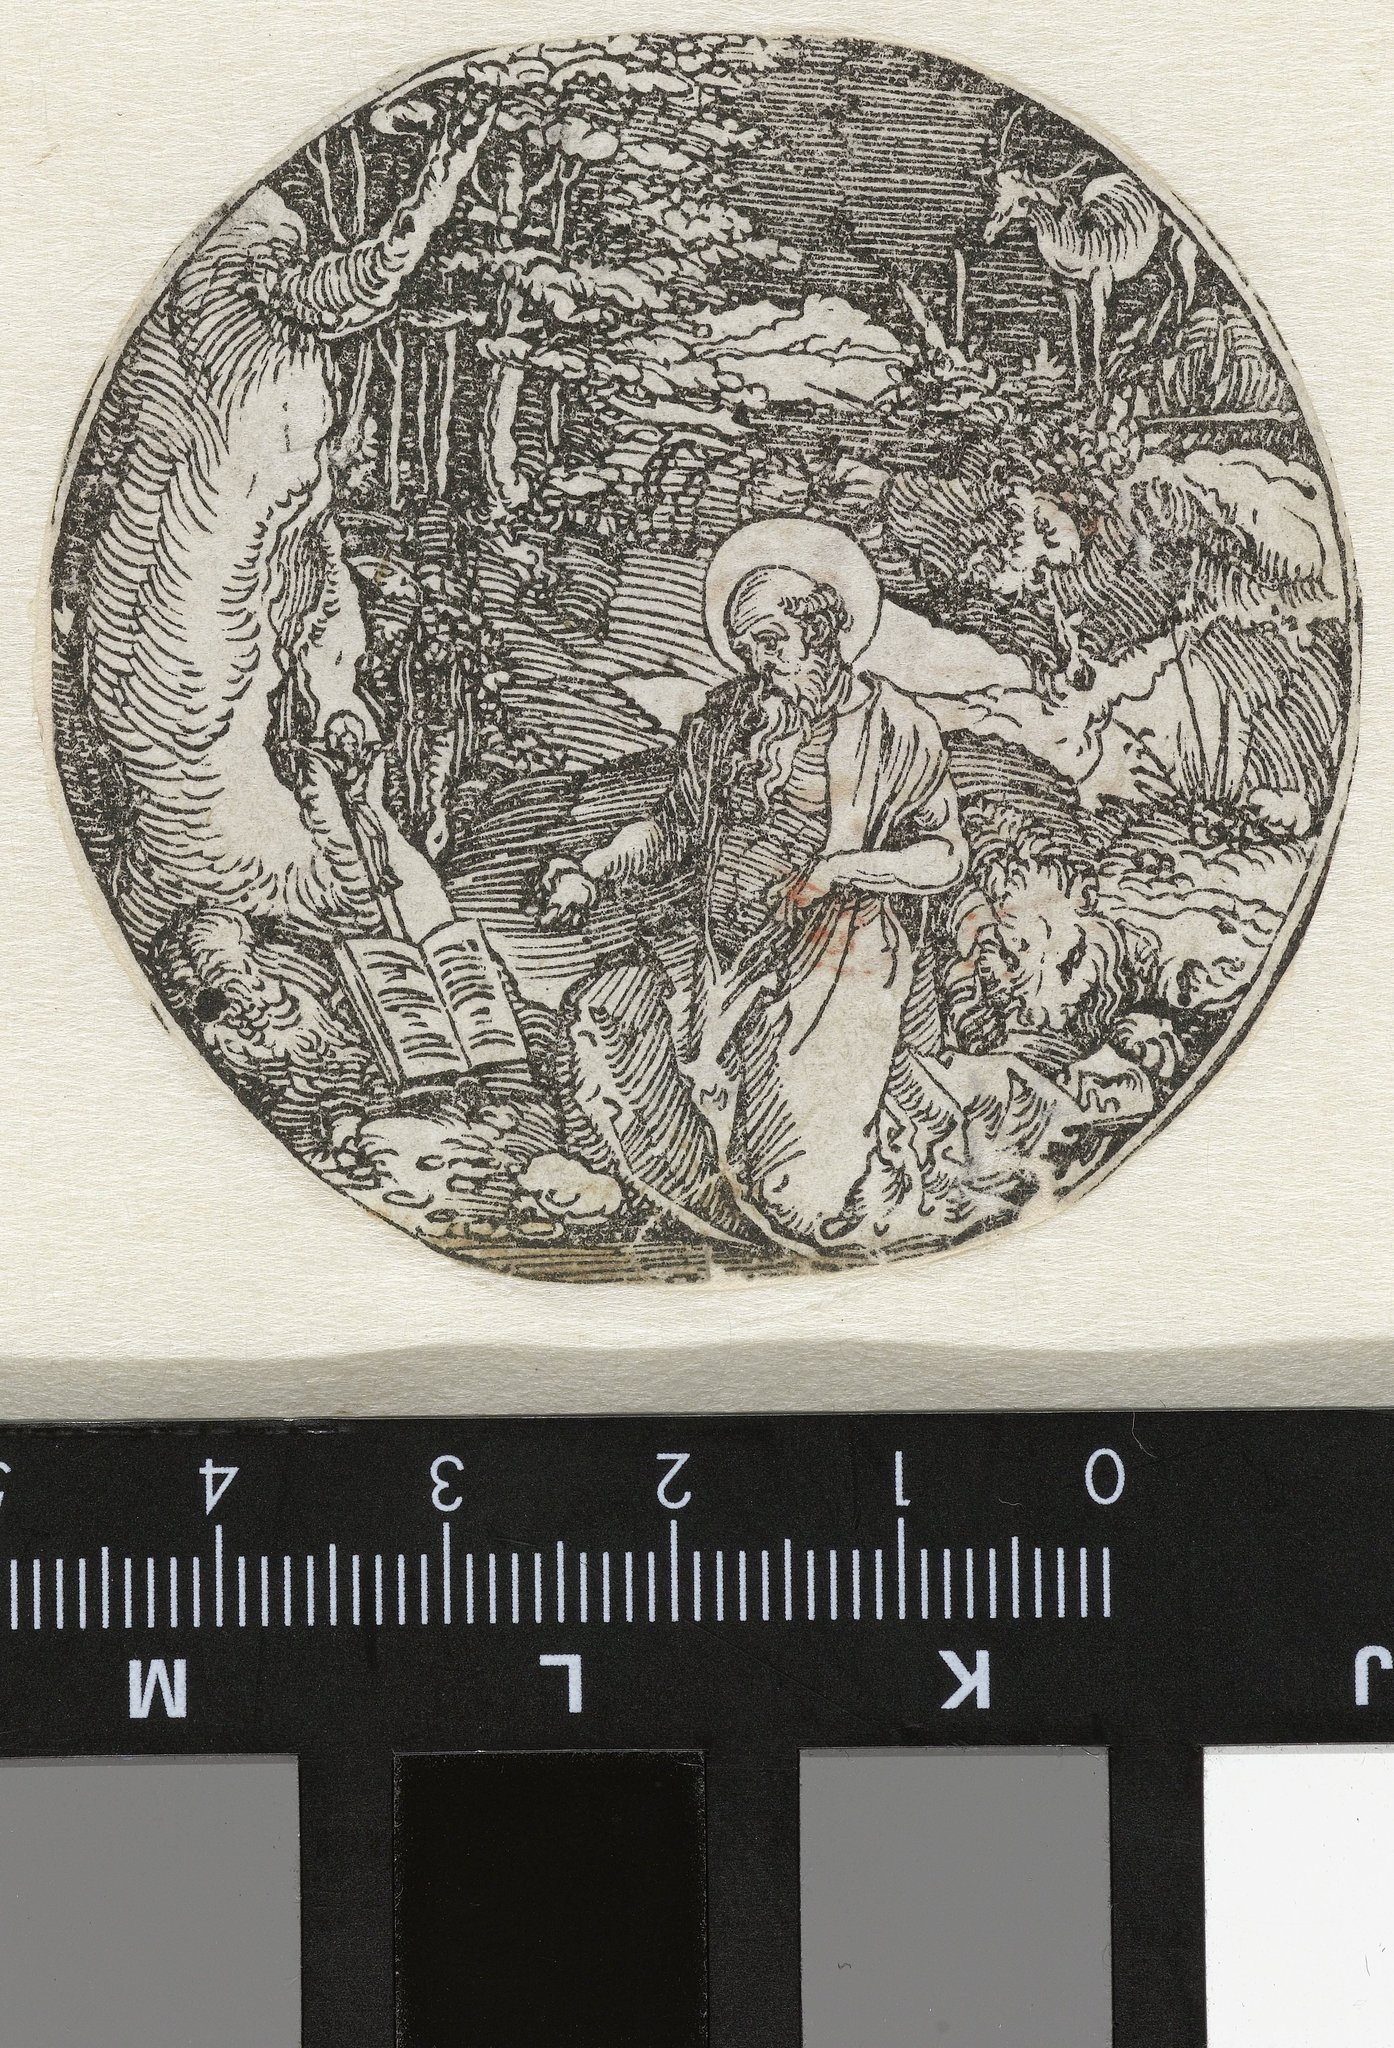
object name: print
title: De Heilige Hiëronymus in de wildernis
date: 1500-1515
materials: paper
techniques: woodcut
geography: nuremberg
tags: st. jerome as penitent in the desert, half naked, kneeling before a crucifix and holding a stone in his hand to beat his breast; a skull (and other 'vanitas' symbols), sometimes a scorpion and a snake beside him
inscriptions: collector's mark: Lugt 240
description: Ronde voorstelling van de Heilige Hiëronymus, bij een boom geknield voor een boek en een crucifix, een steen in de hand. Achter hem ligt een leeuw.